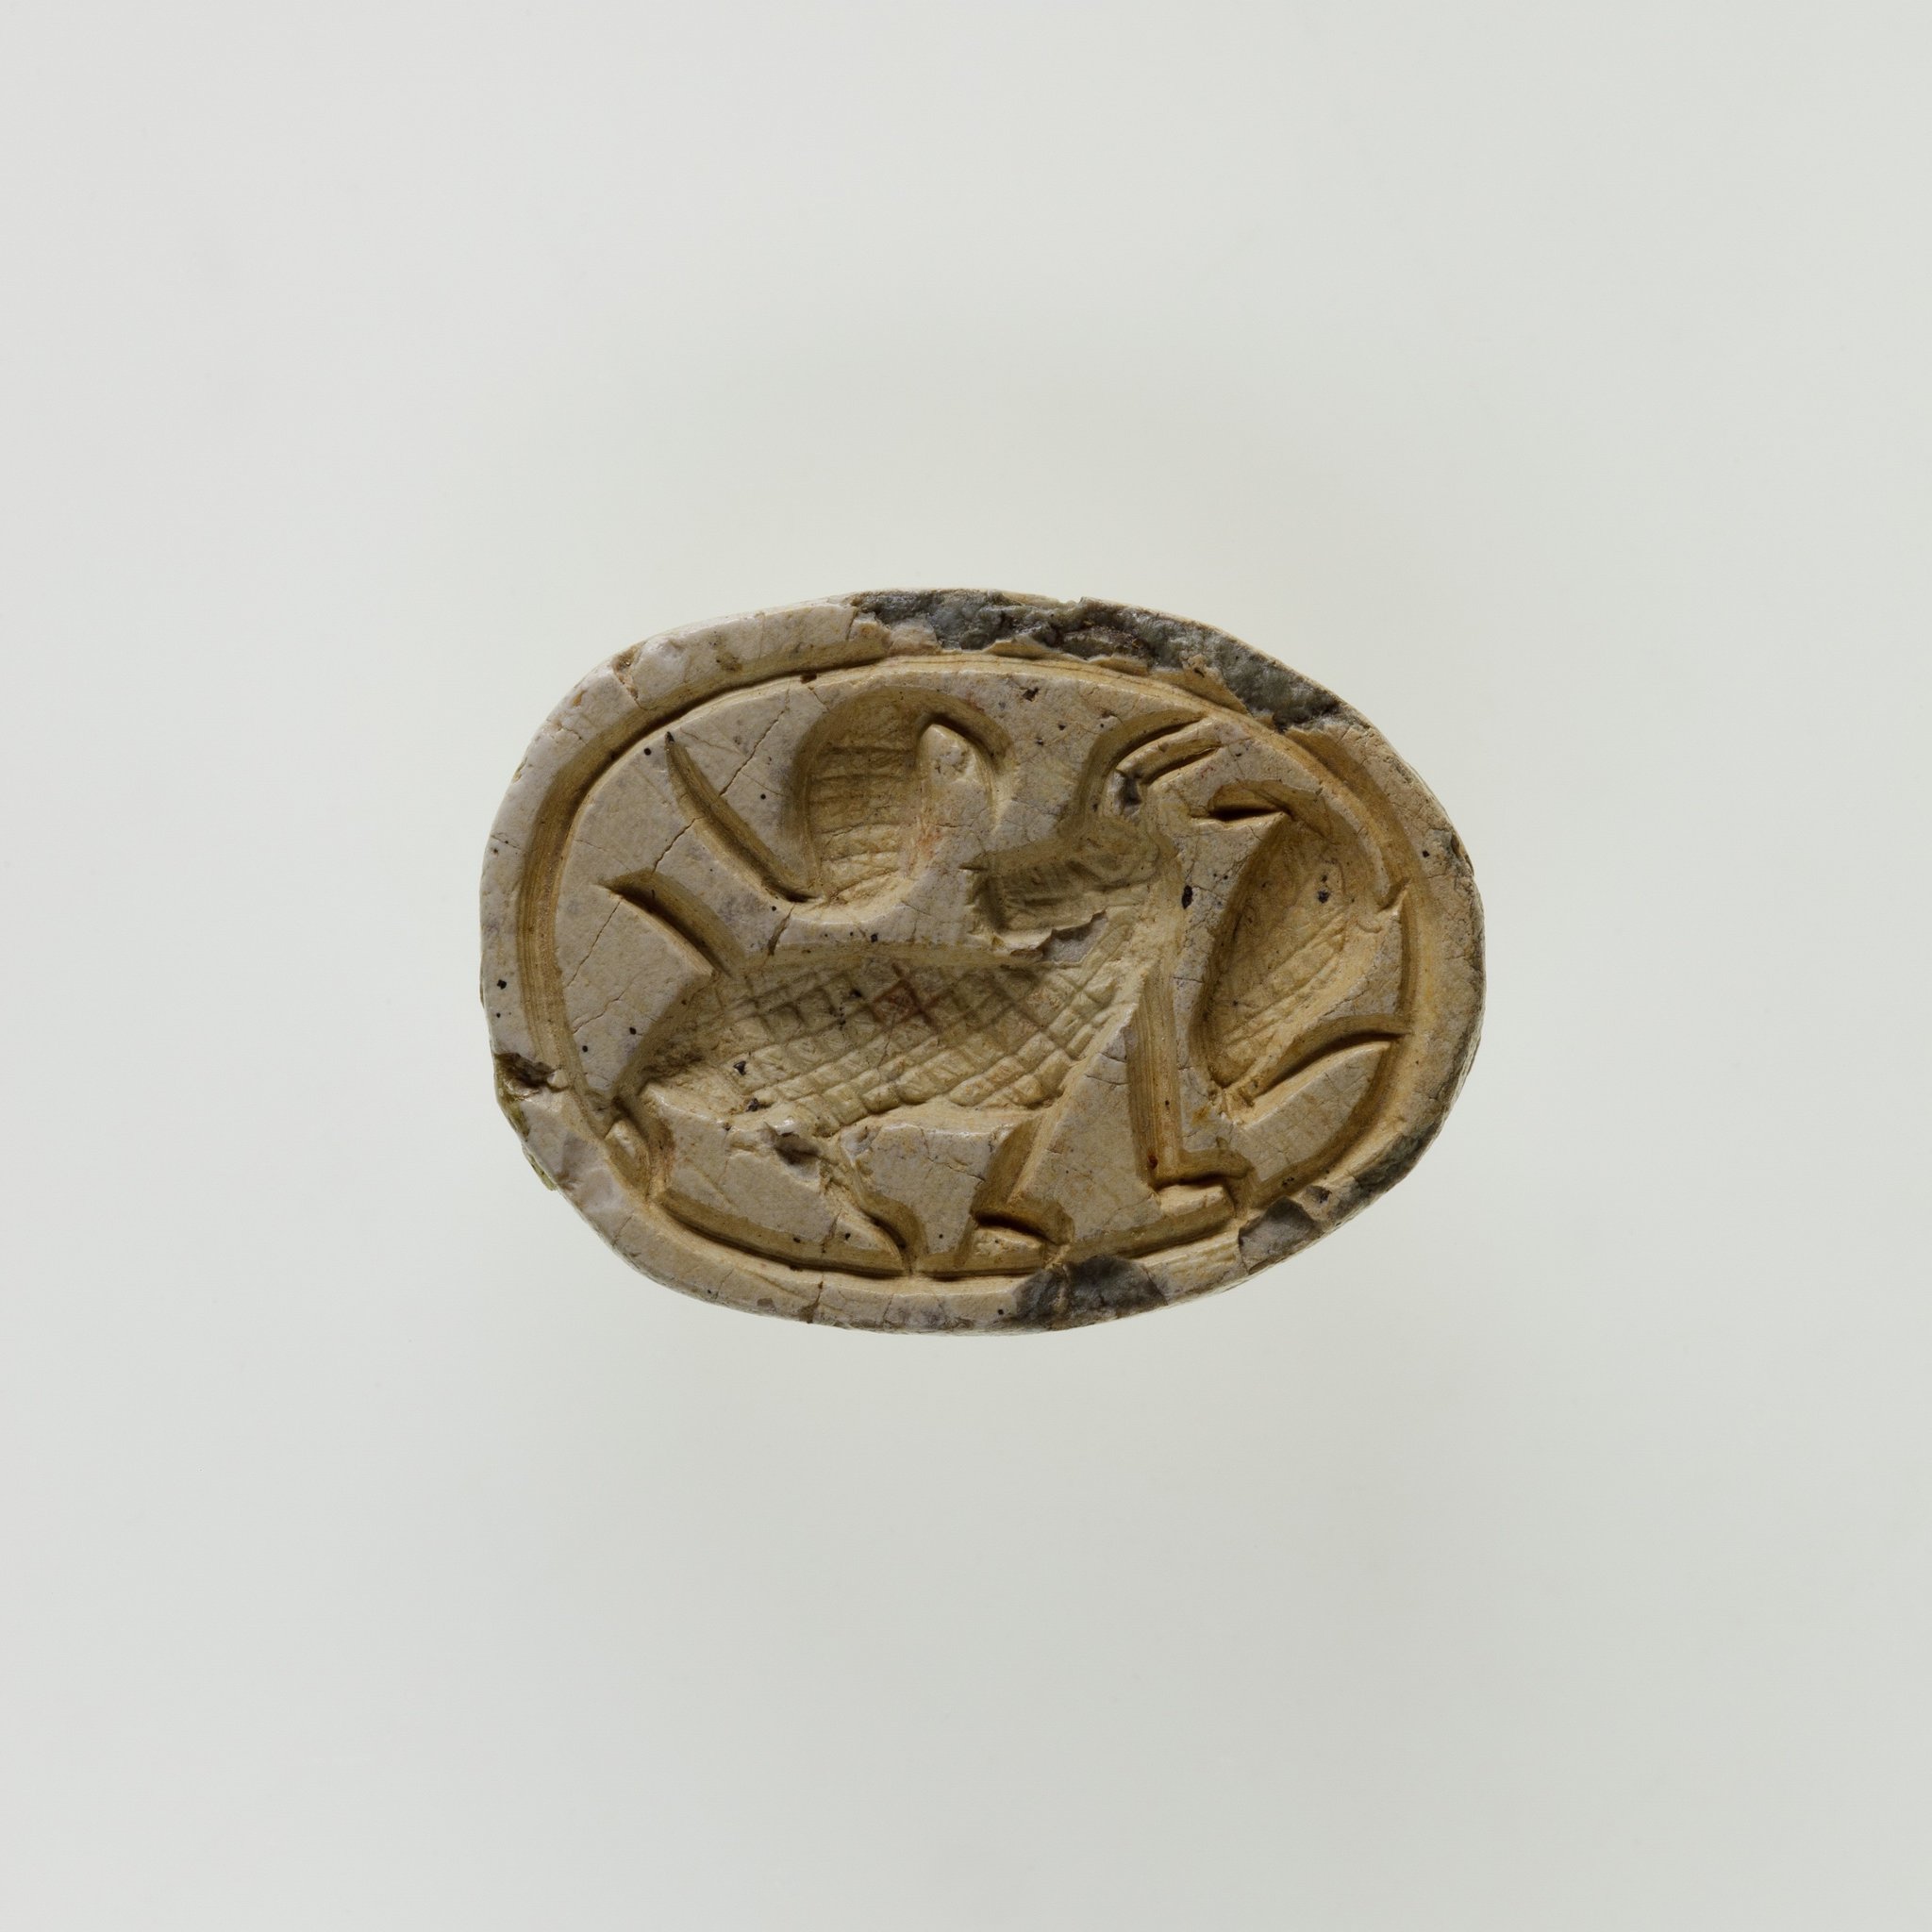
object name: scarab, animal, antelope, uraeus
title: Scarab with Horned Animal and Uraei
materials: stone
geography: egypt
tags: scarabs